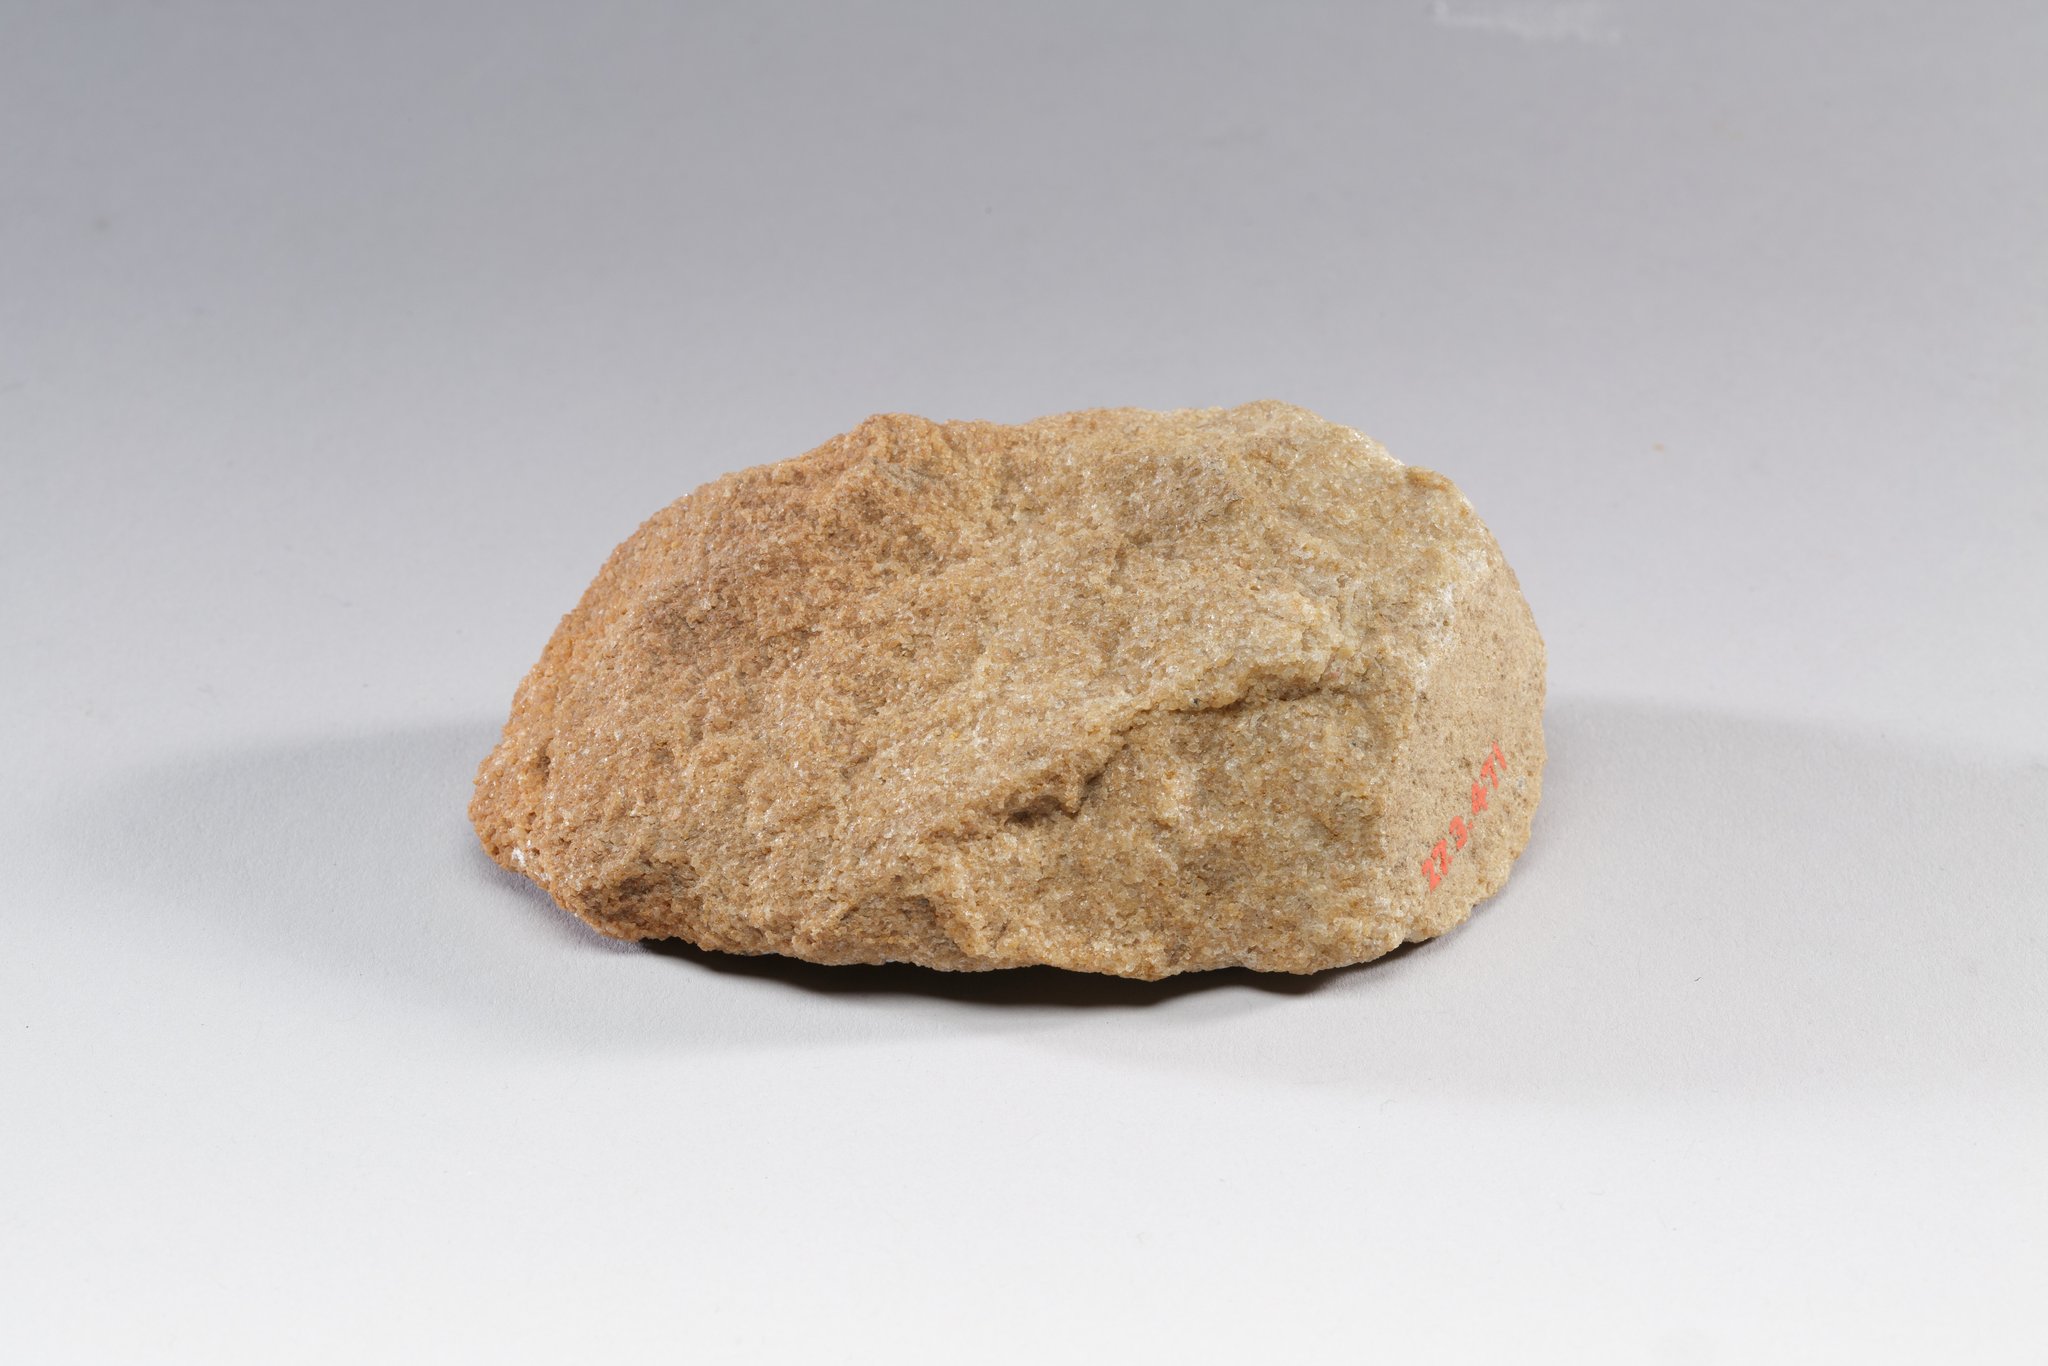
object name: rubbing stone, tool, senenmut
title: Rubbing Stone (?)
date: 1479-1458 BCE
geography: egypt